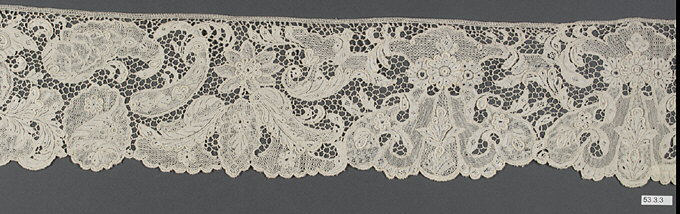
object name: border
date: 1701-1750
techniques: lace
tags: flowers